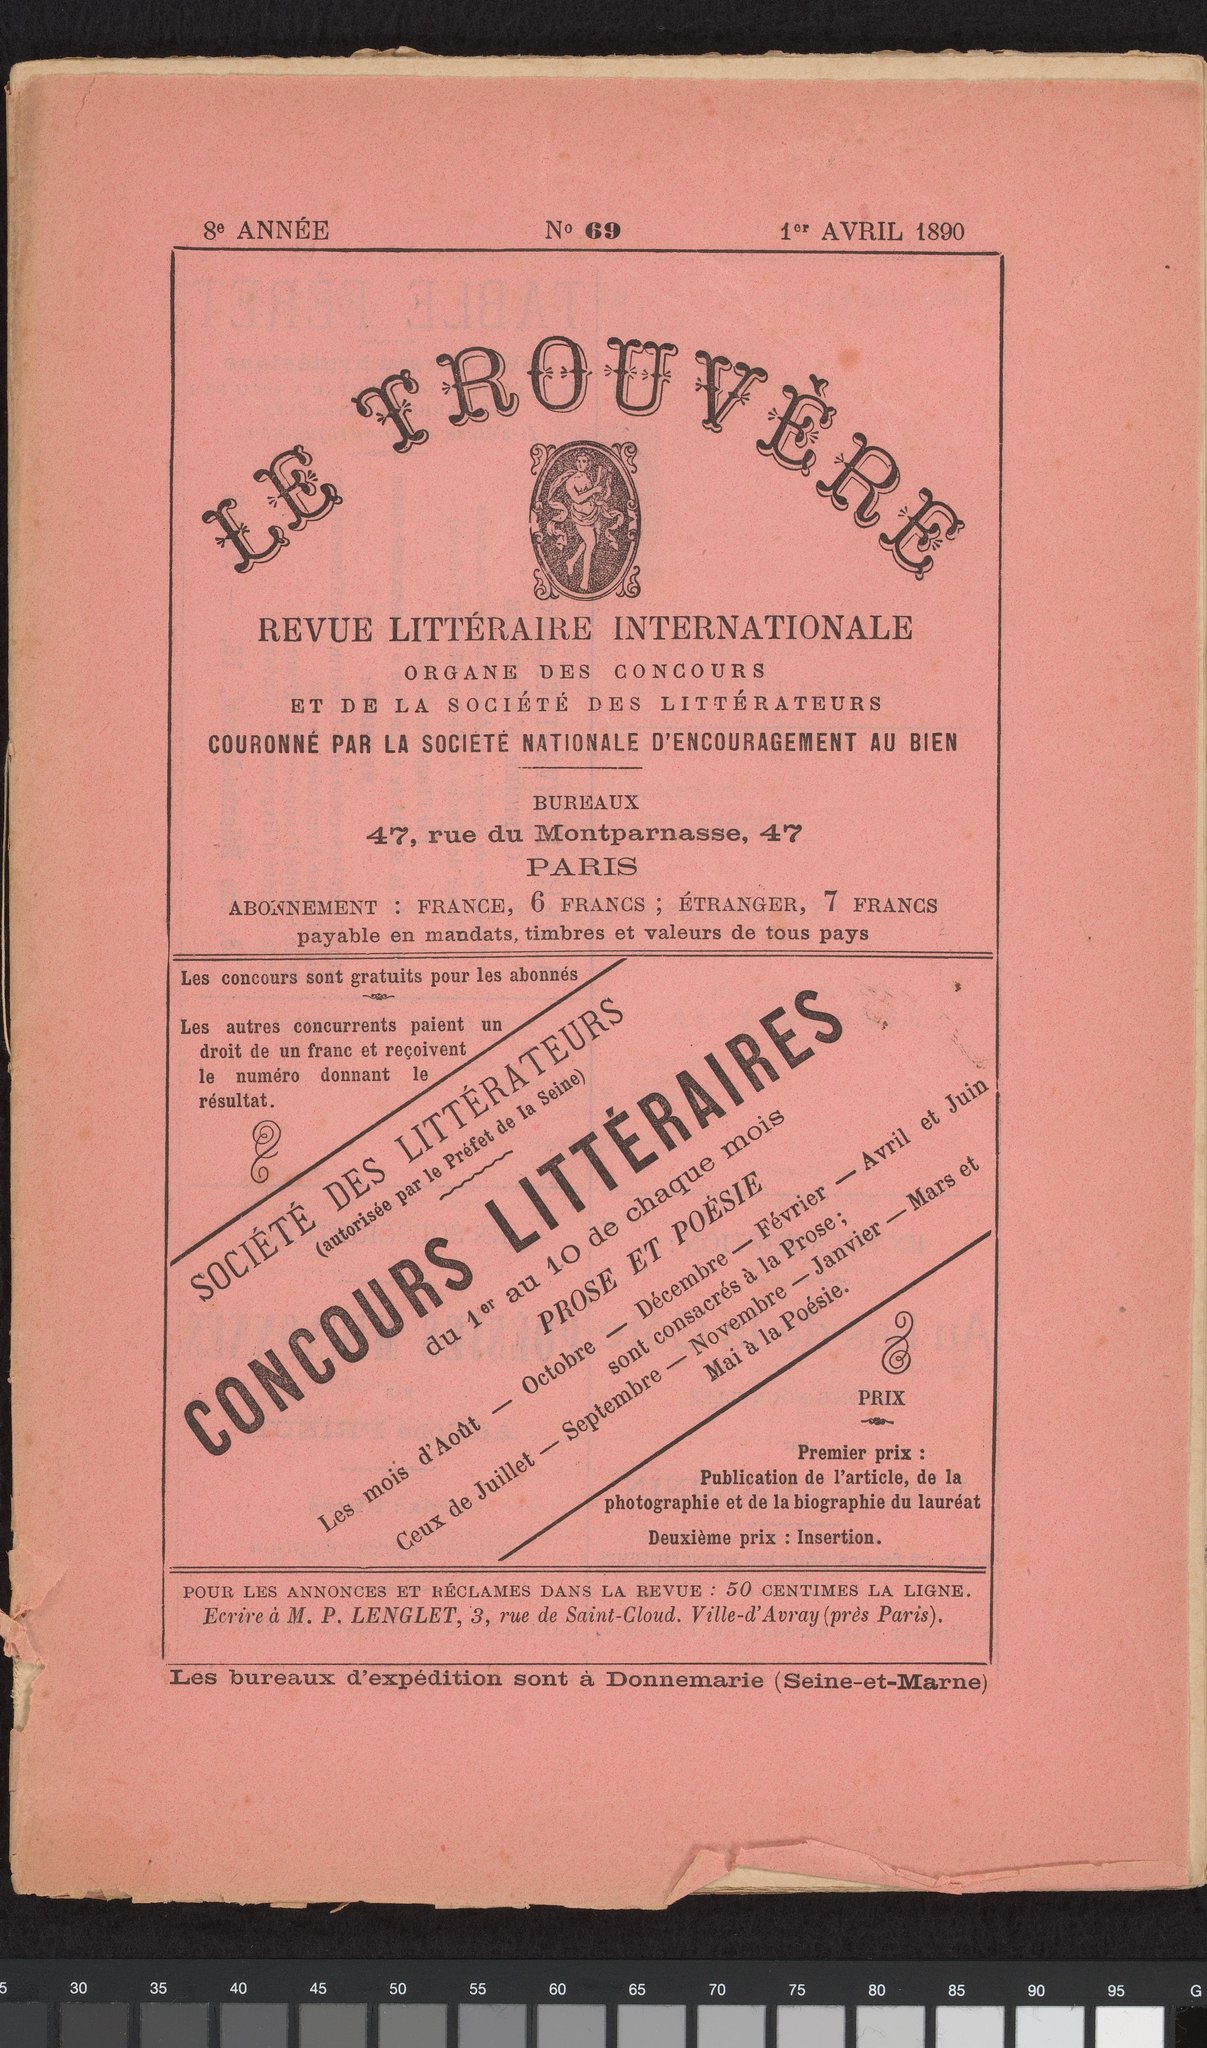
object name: book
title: Le trouvère No 69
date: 1804-1890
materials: paper, photographic support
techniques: albumen print, printing, engraving